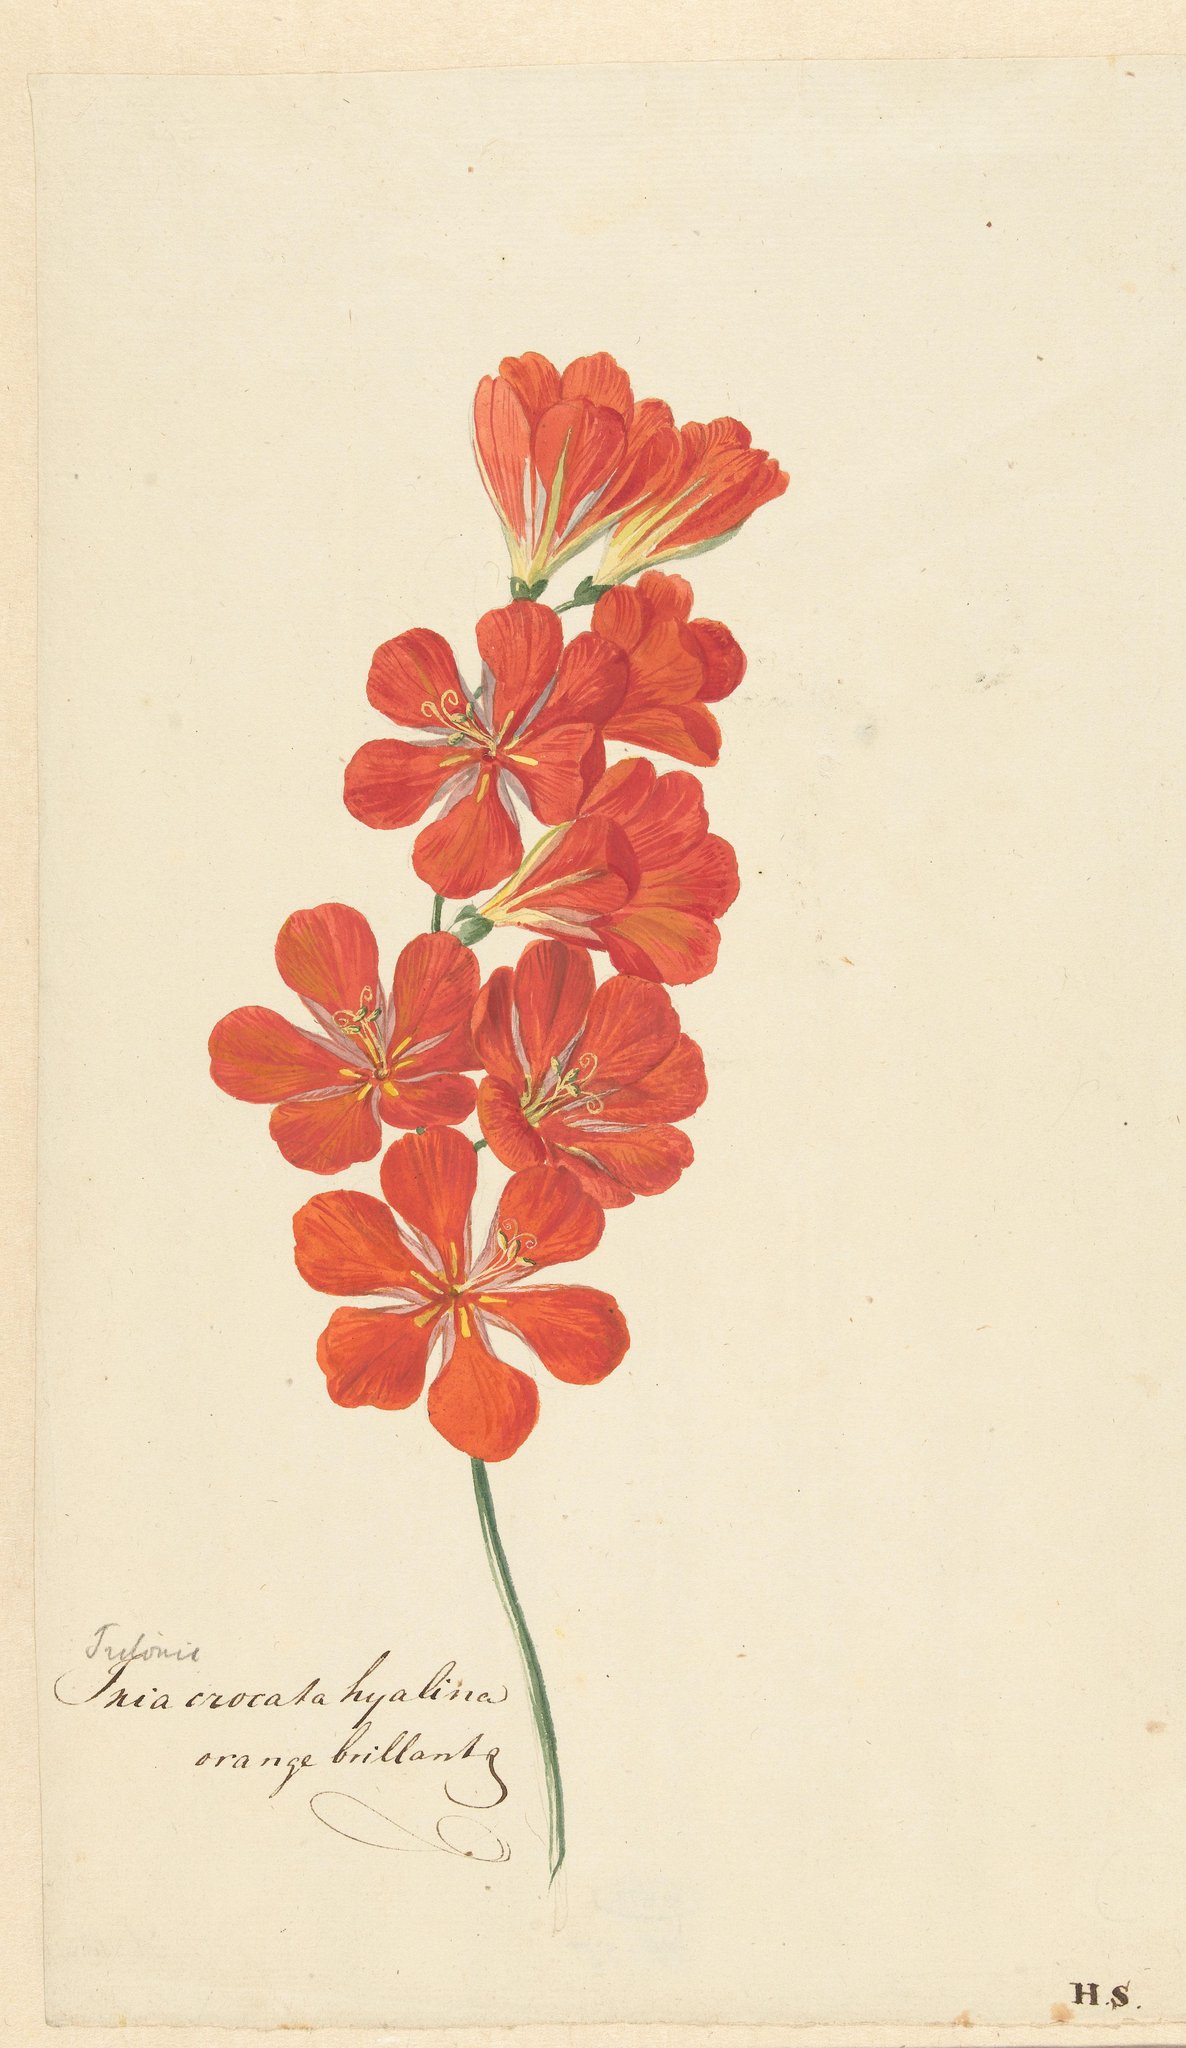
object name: drawing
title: Tritonia Crocata (Flame Freesia)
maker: hendrik schwegman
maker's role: draughtsman, print maker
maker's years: 1761-1816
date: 1780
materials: paper, watercolor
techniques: brush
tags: flowers: freesia, flowers: tritonia crocata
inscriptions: inscription: ‘Trilonie (?)’, initials: ‘Rechtsonder: H.S.’, inscription: ‘Ixia crocata hyalina / orange brillante’